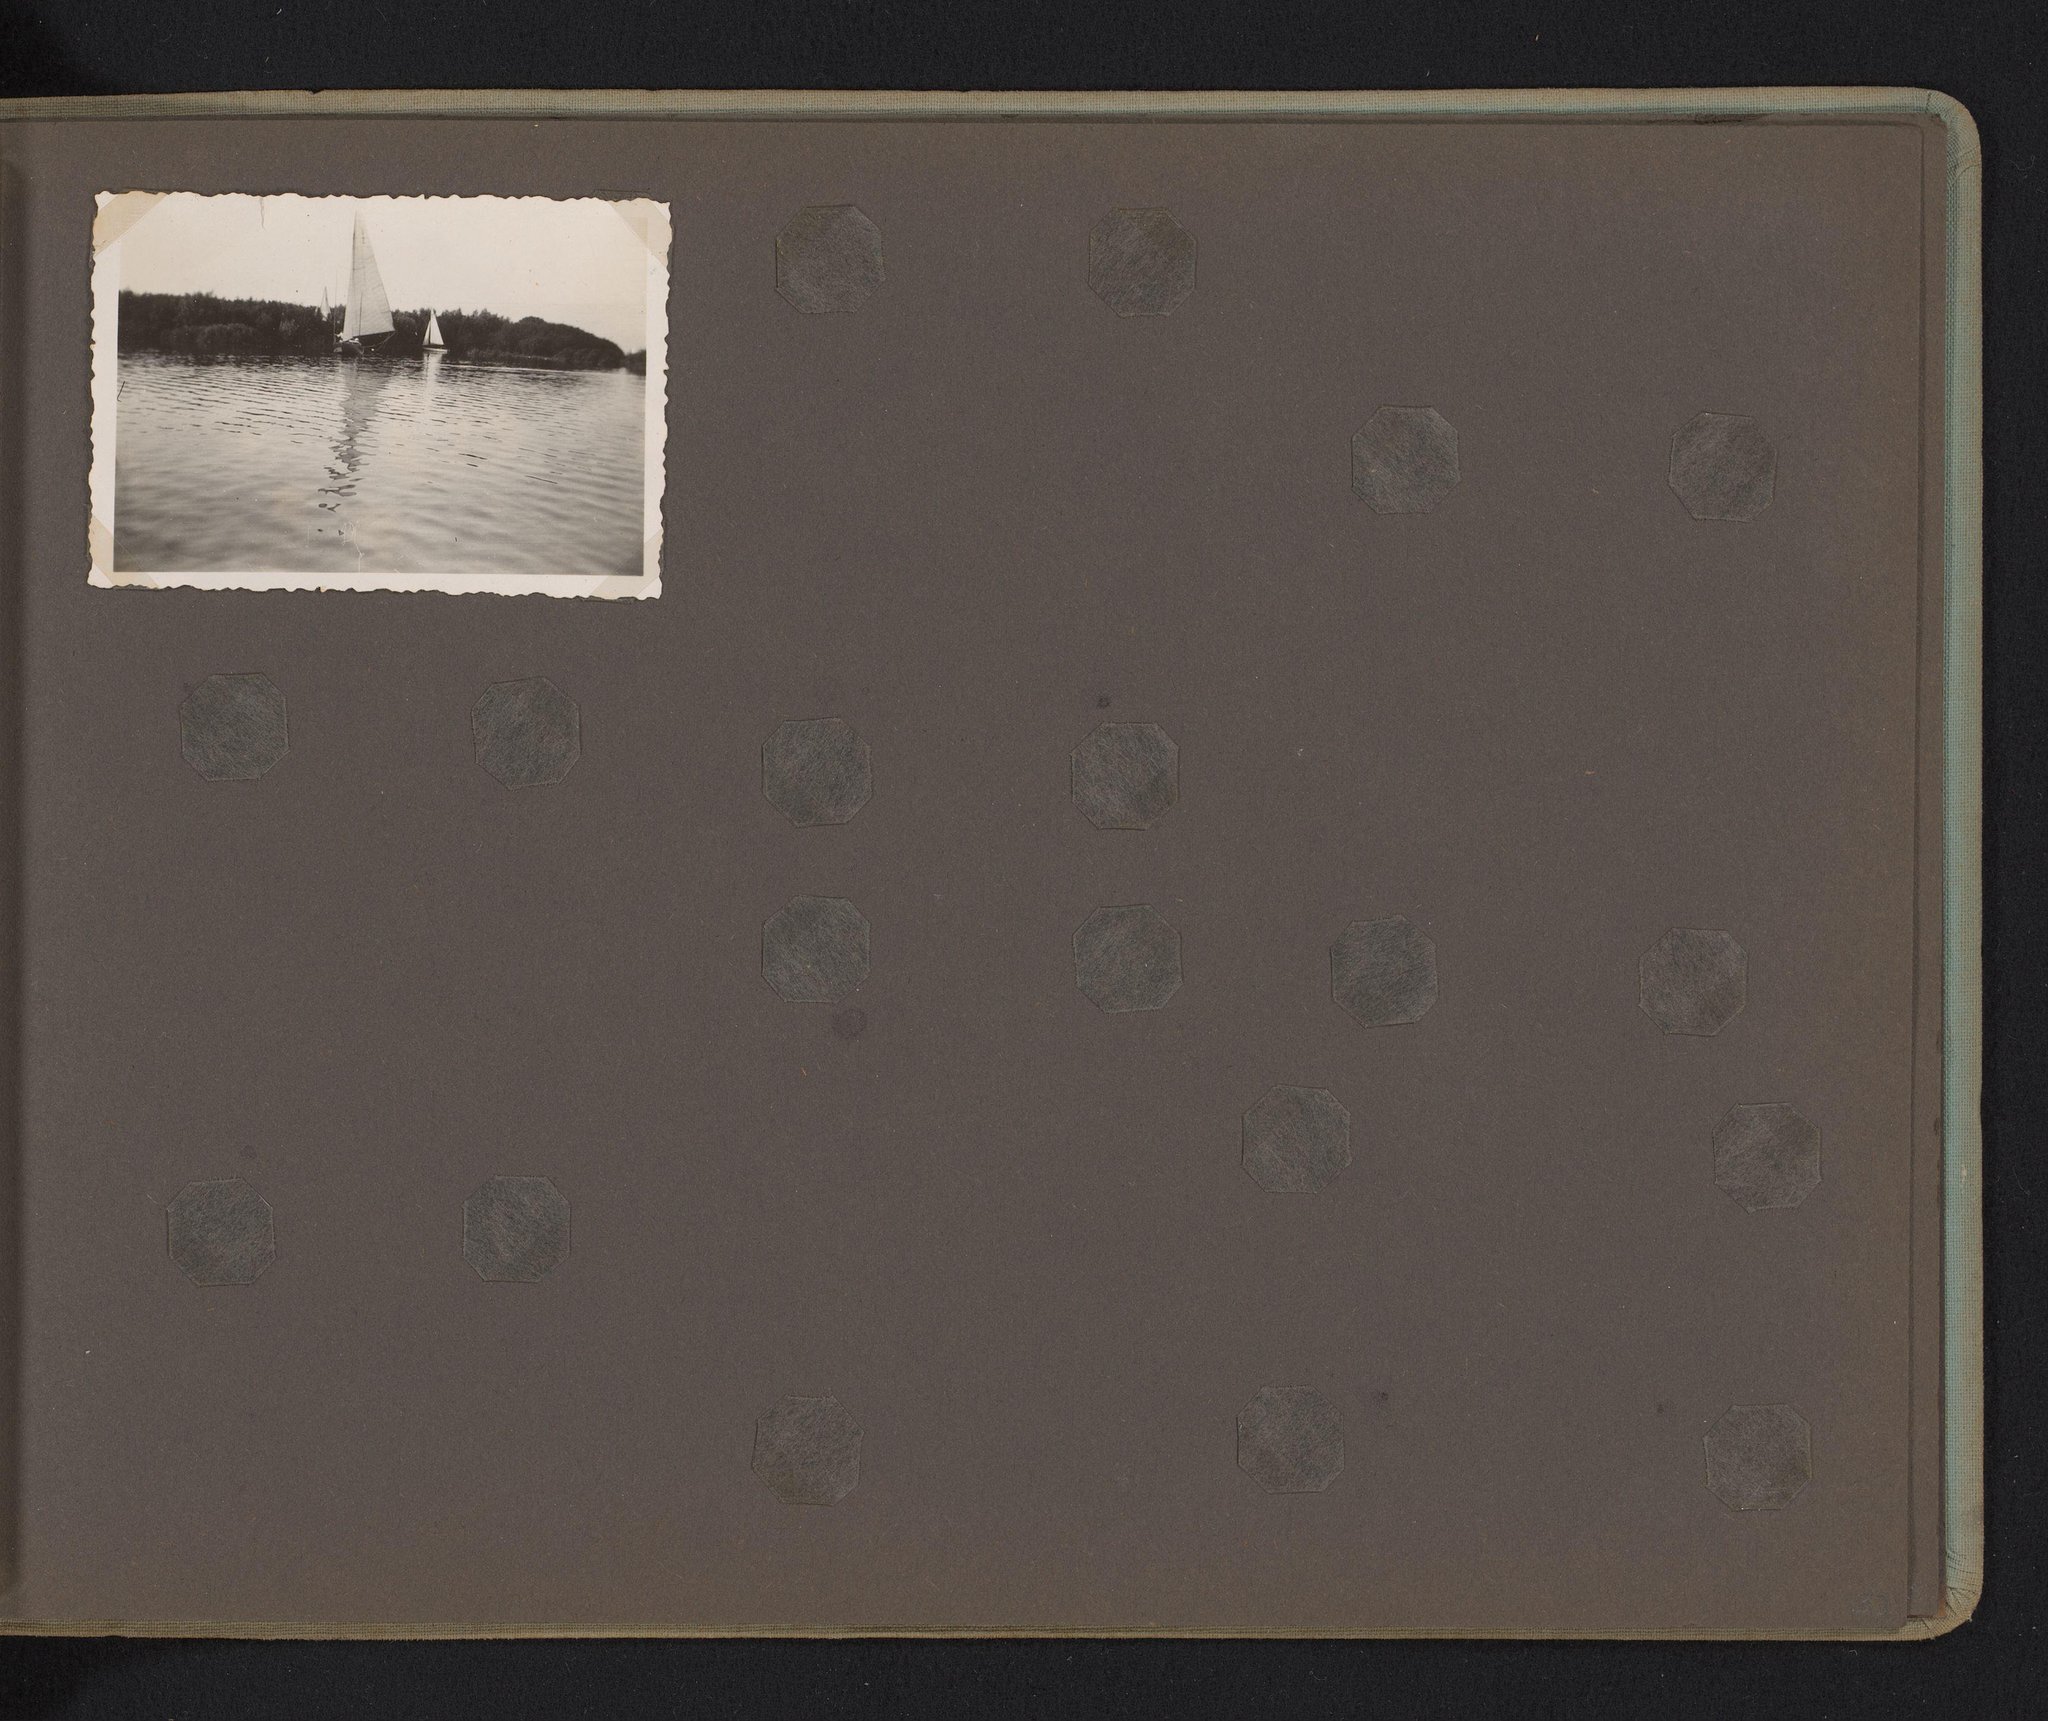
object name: album leaf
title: Zeilvakantie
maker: Anonymous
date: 1935-1945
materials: cardboard, photographic support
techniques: gelatin silver print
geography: netherlands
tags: sailing-ship, sailing-boat, outing, pleasure trip, netherlands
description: Albumblad met een foto van een zeilvakantie. Onderdeel van het fotoalbum van een jonge vrouw, ca. 1935-1945.